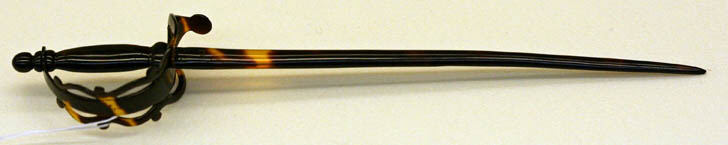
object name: hair accessory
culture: american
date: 1870-1879